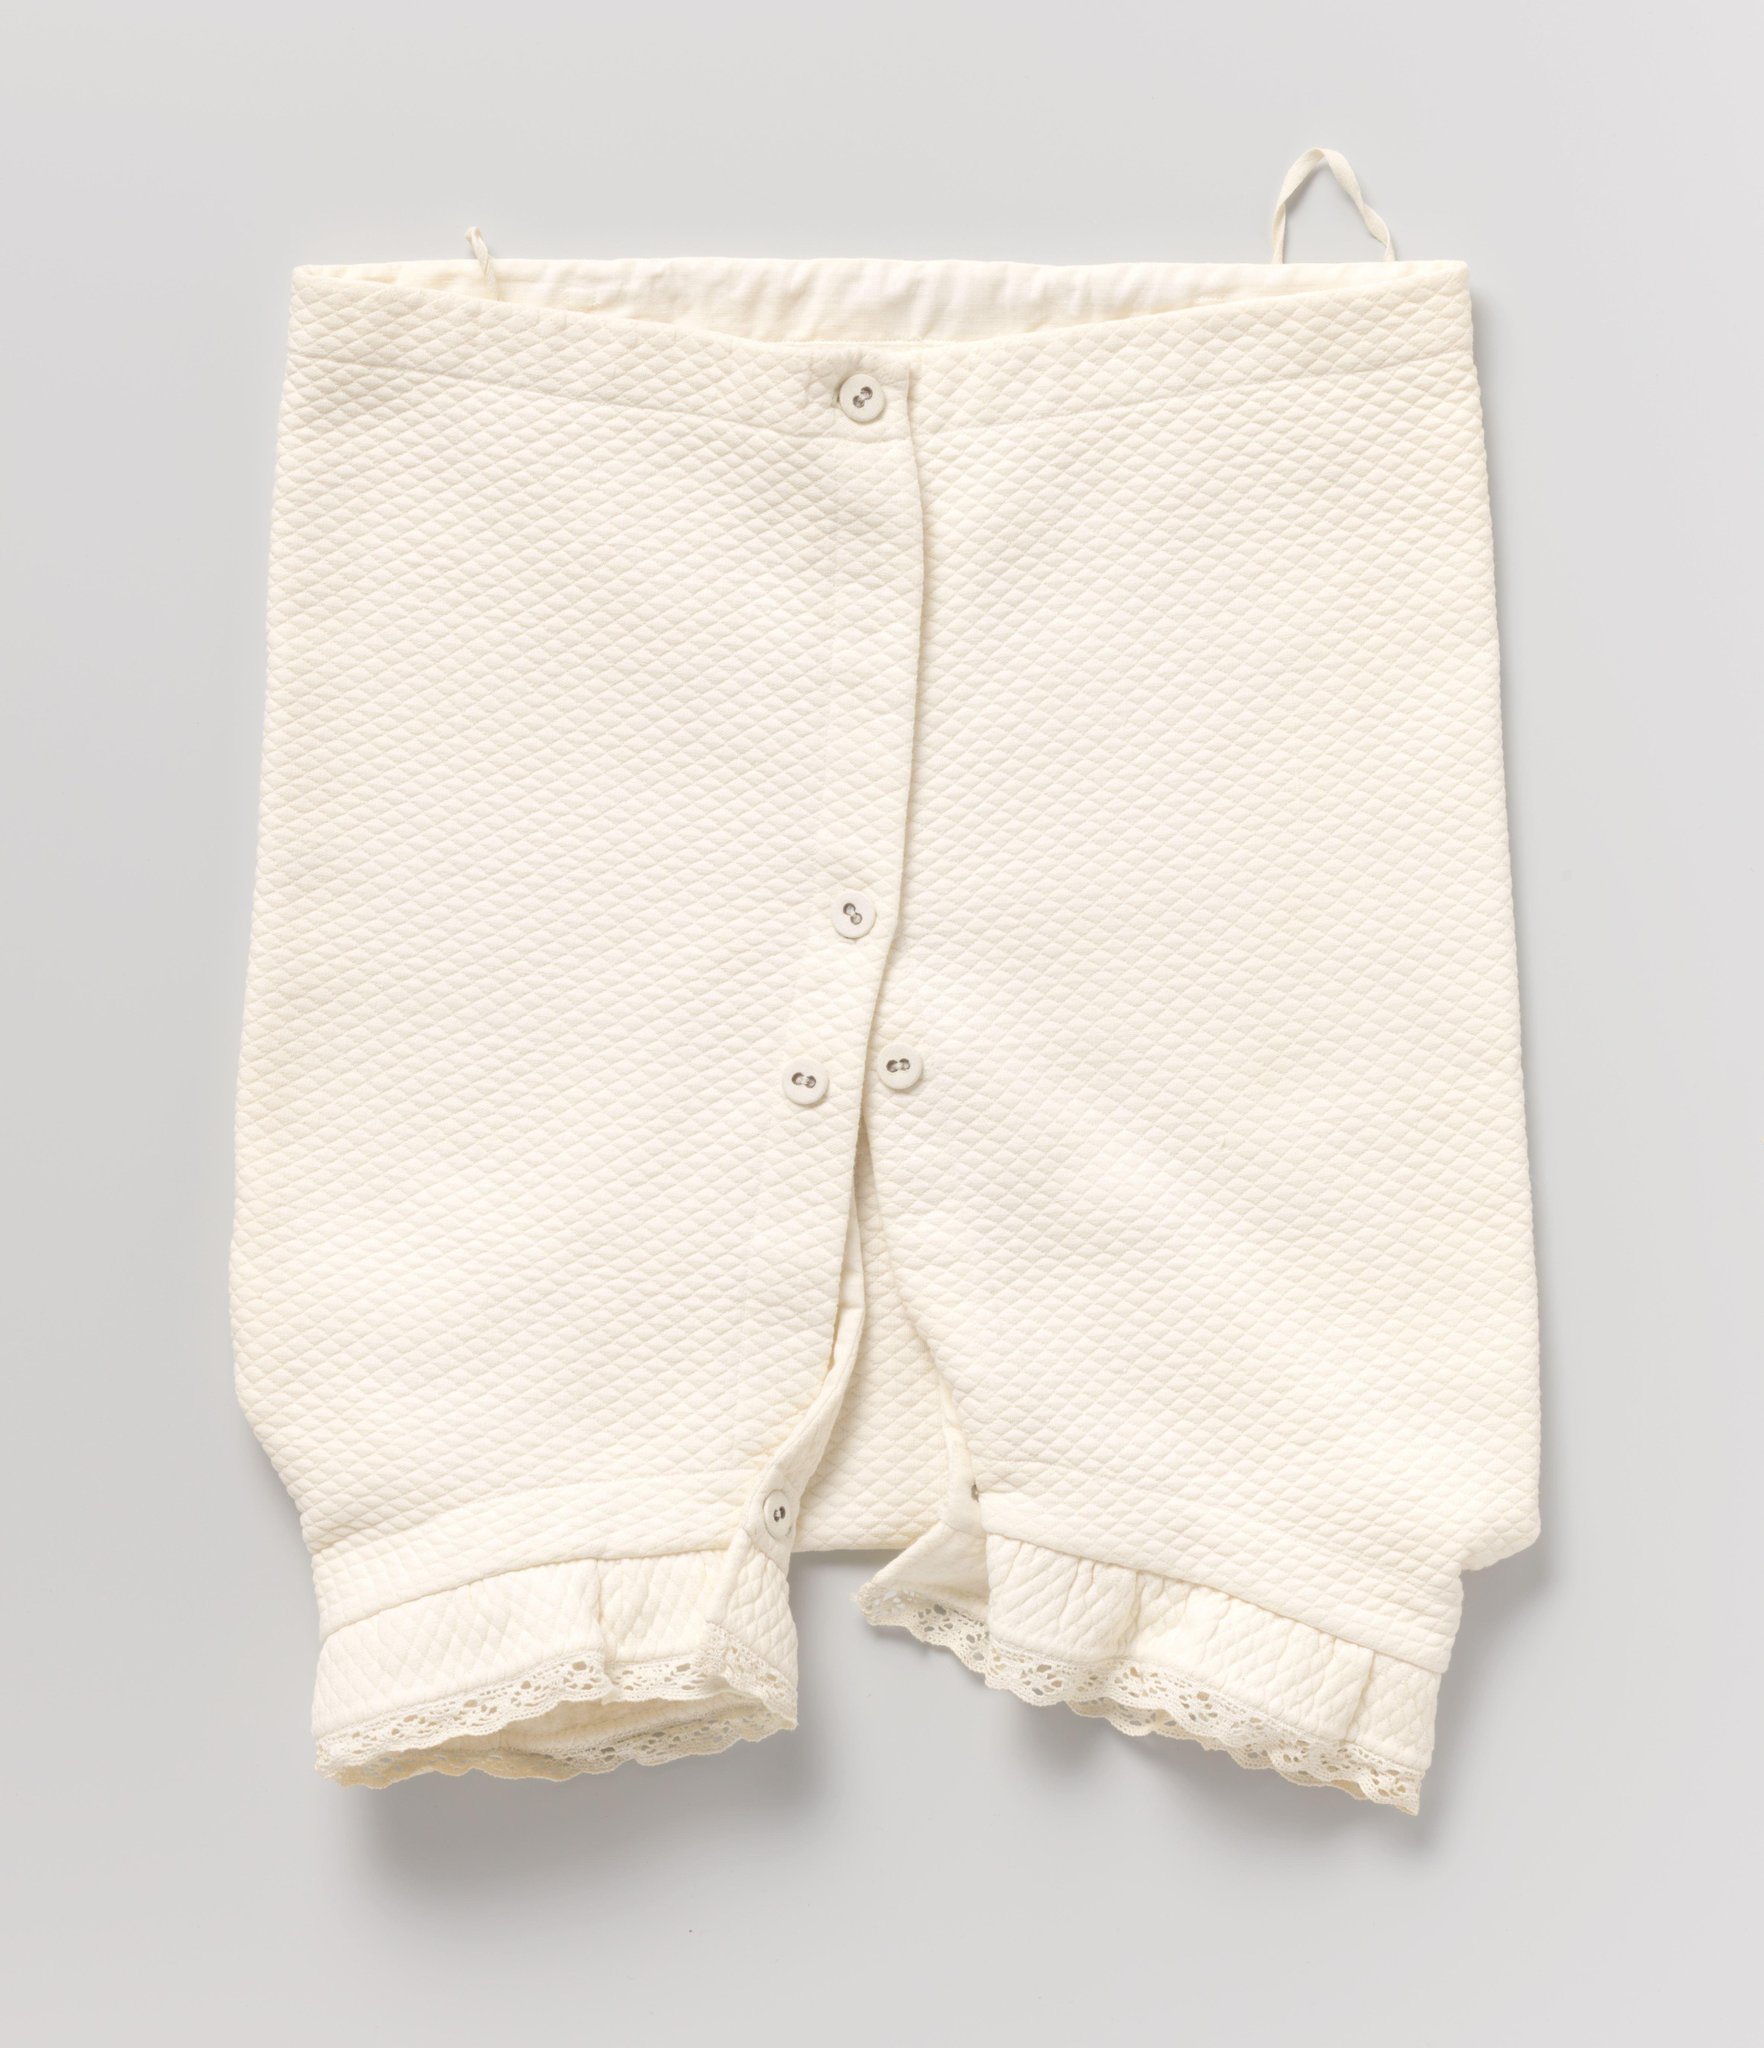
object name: pilch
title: Luierbroek van katoenen piqué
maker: Anonymous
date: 1900-1925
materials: textile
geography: netherlands